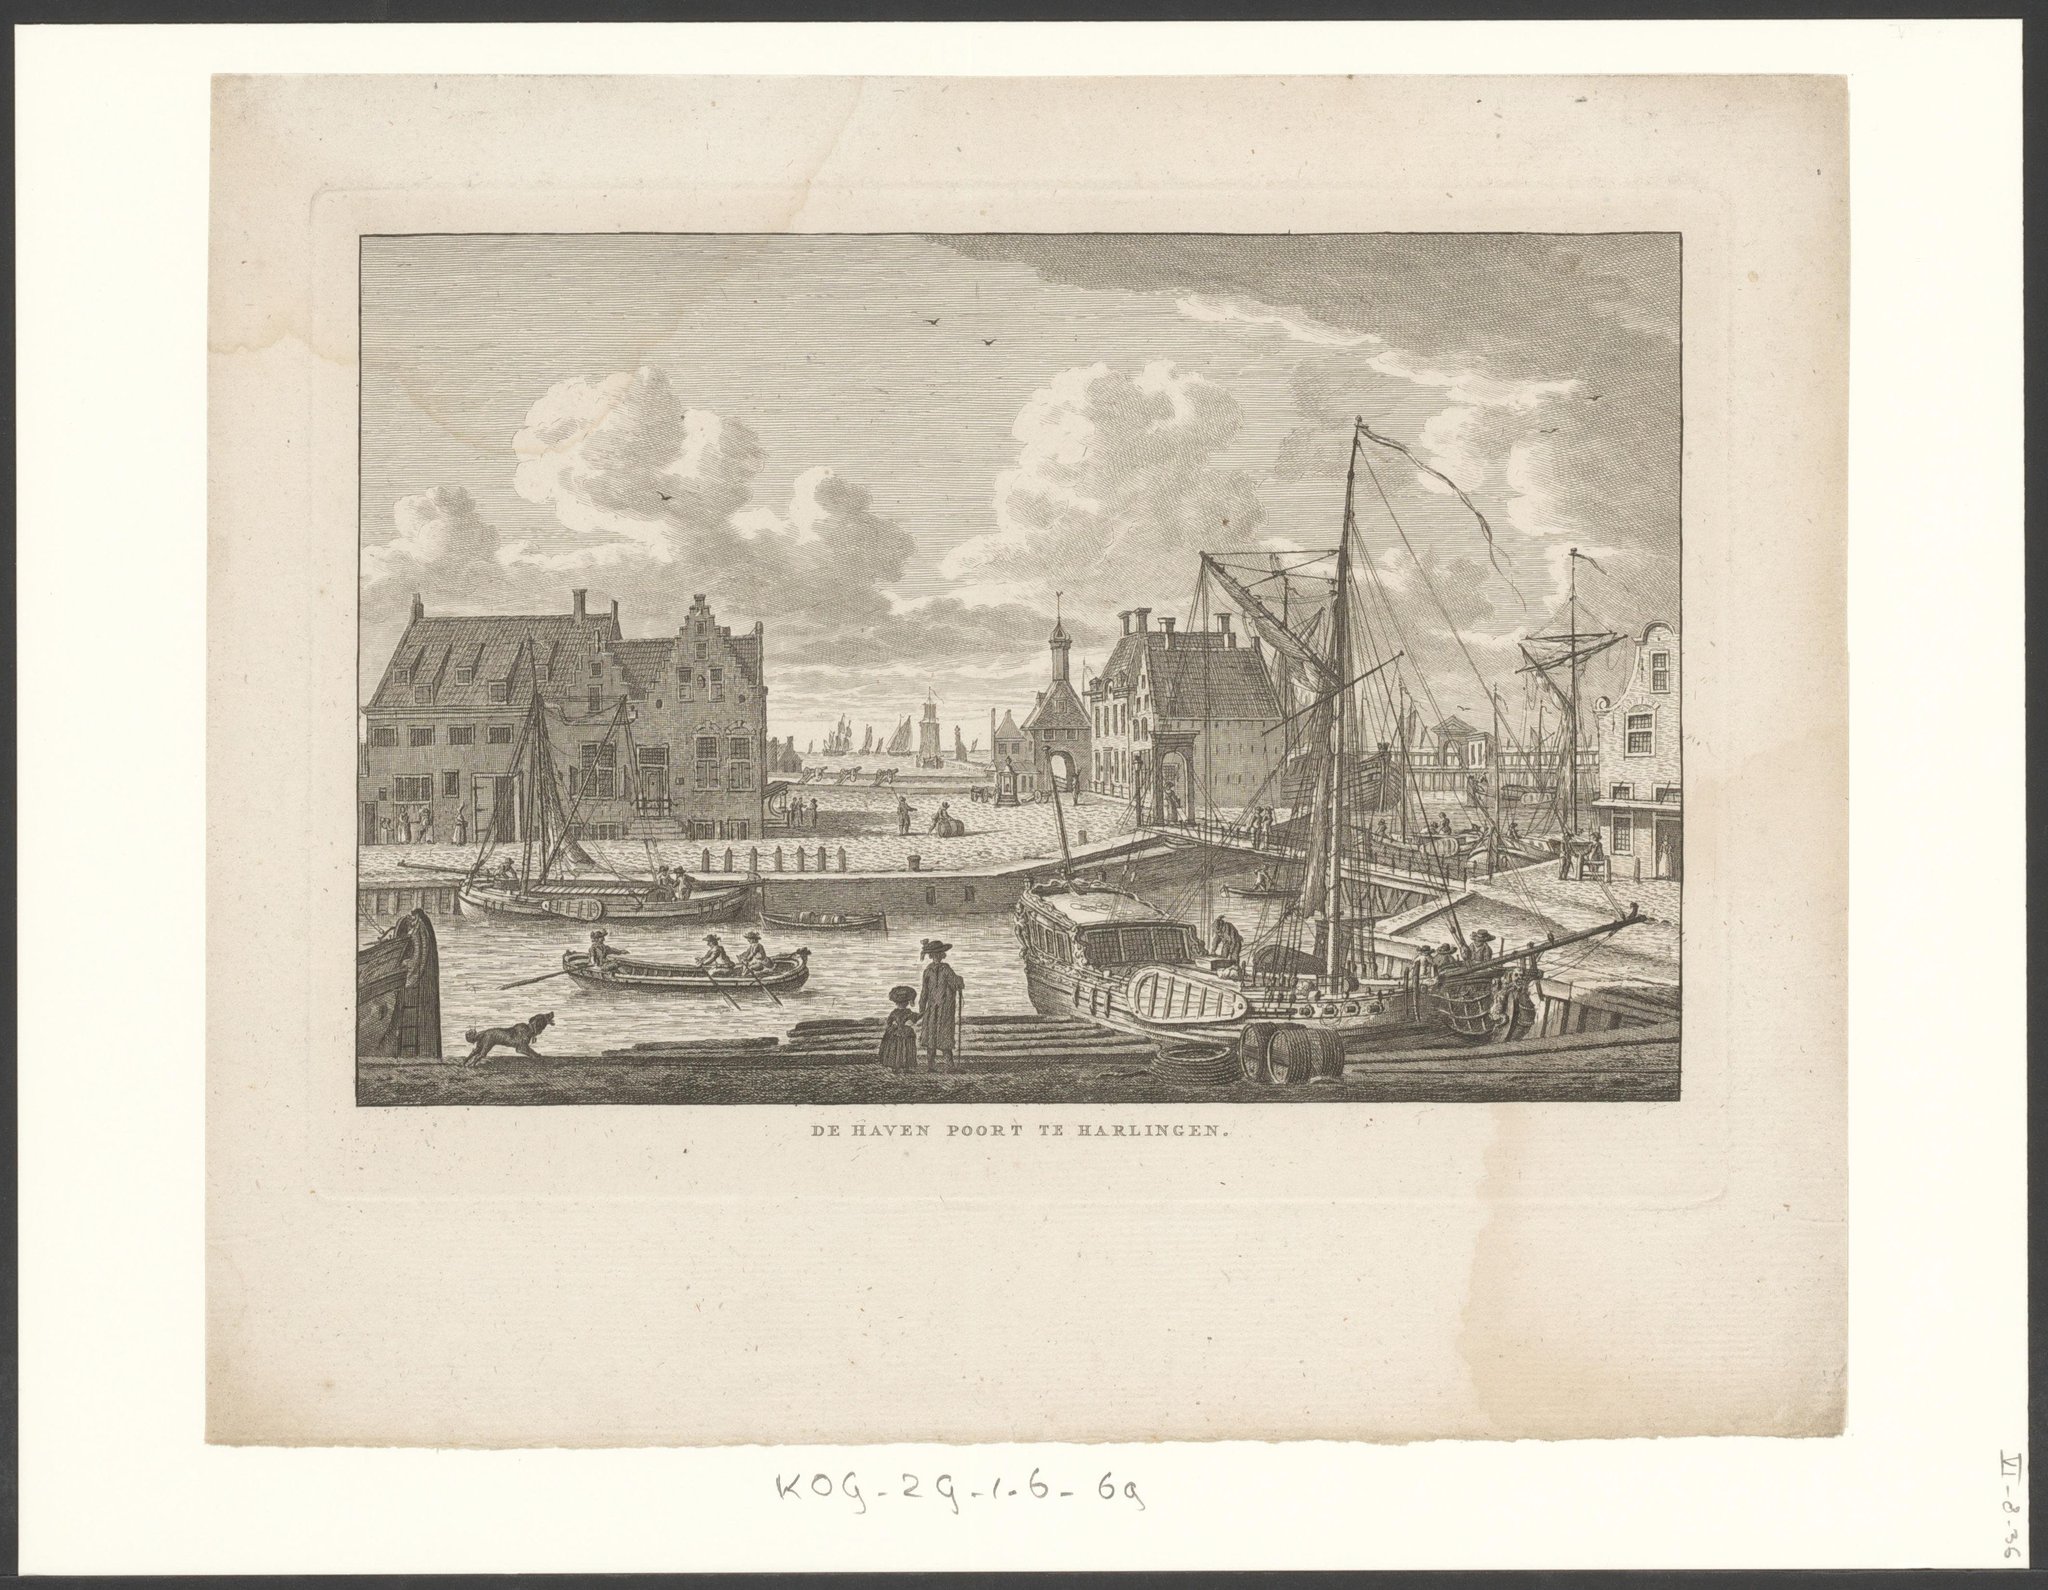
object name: print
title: Havenpoort te Harlingen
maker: carel frederik bendorp (i)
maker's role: print maker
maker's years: 1736-1814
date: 1786-1792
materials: paper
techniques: engraving, etching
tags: harbour, ships (in general) - cc - more than one ship, city-gate, harlingen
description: Prent waarschijnlijk uit: Vaderlandsche gezichten, of afbeeldingen van den tegenwoordigen staat der Vereenigde Nederlanden (…). Amsterdam: Hendrik Gartman, Willem Vermandel en Jan Willem Smit, 1786-1792. Uitgegeven in afleveringen met ieder een eigen bifolium en inhoudsopgave. Alle prenten in deze publicatie zijn gemaakt door Carel Frederik Bendorp (I) en, in de meeste gevallen, gebaseerd op tekeningen van Jan Bulthuis. Latere staat uitgegeven door Maaskamp als onderdeel van een plaatwerk uit ca. 1824-1825 met 74 (ongenummerde) platen van de belangrijkste topografische gezichten en verschillende zeden en gewoonten in het Verenigd Koninkrijk der Nederlanden.